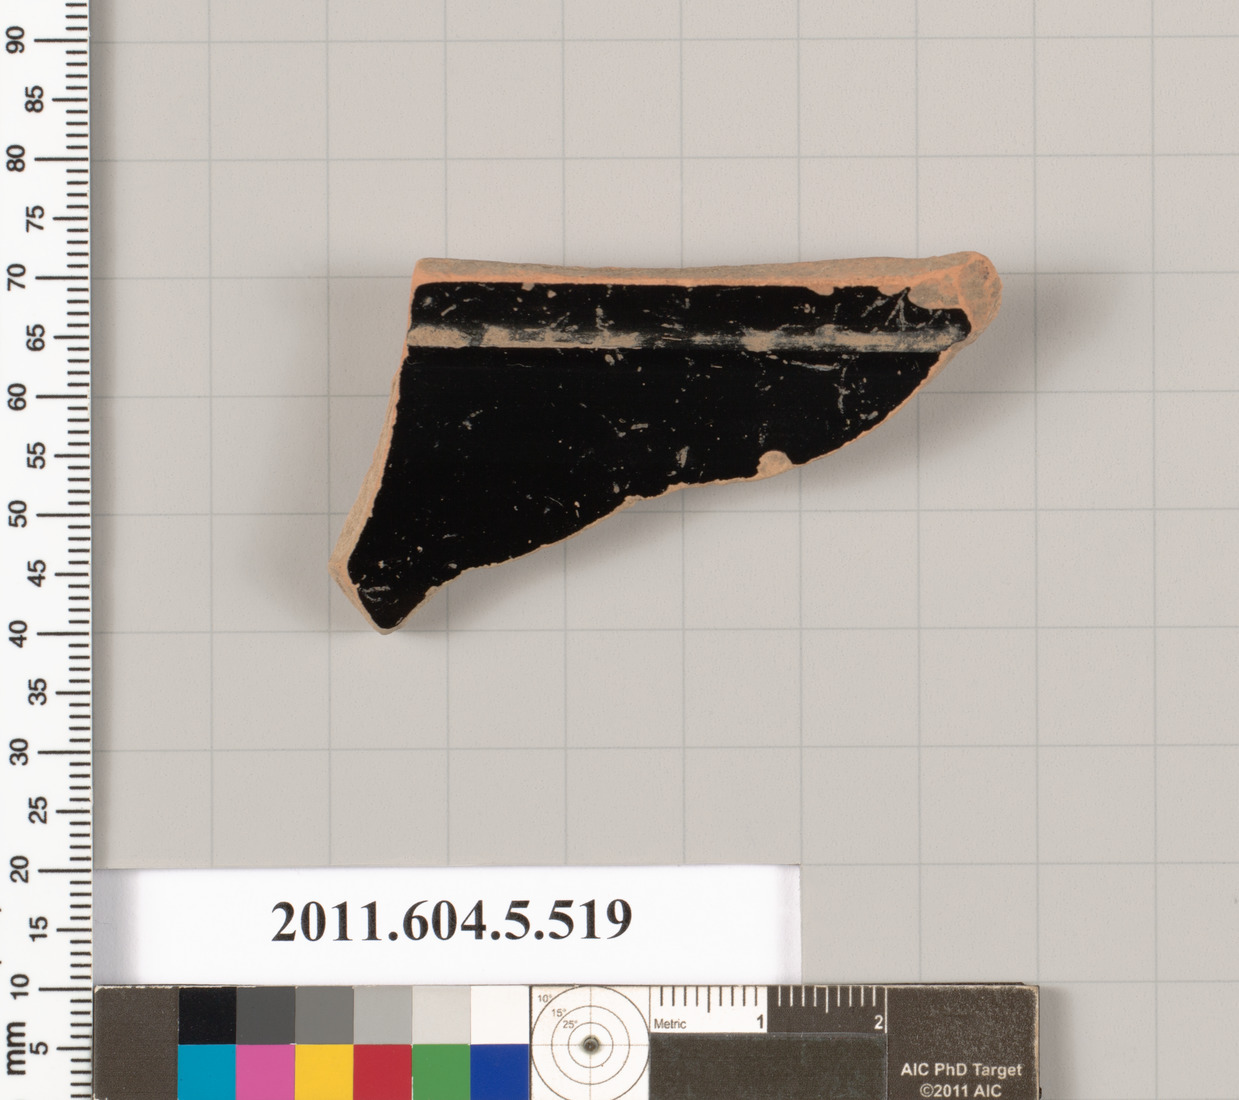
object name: kylix fragment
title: Terracotta fragment of a kylix (drinking cup)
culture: greek, attic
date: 600-401 BCE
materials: terracotta